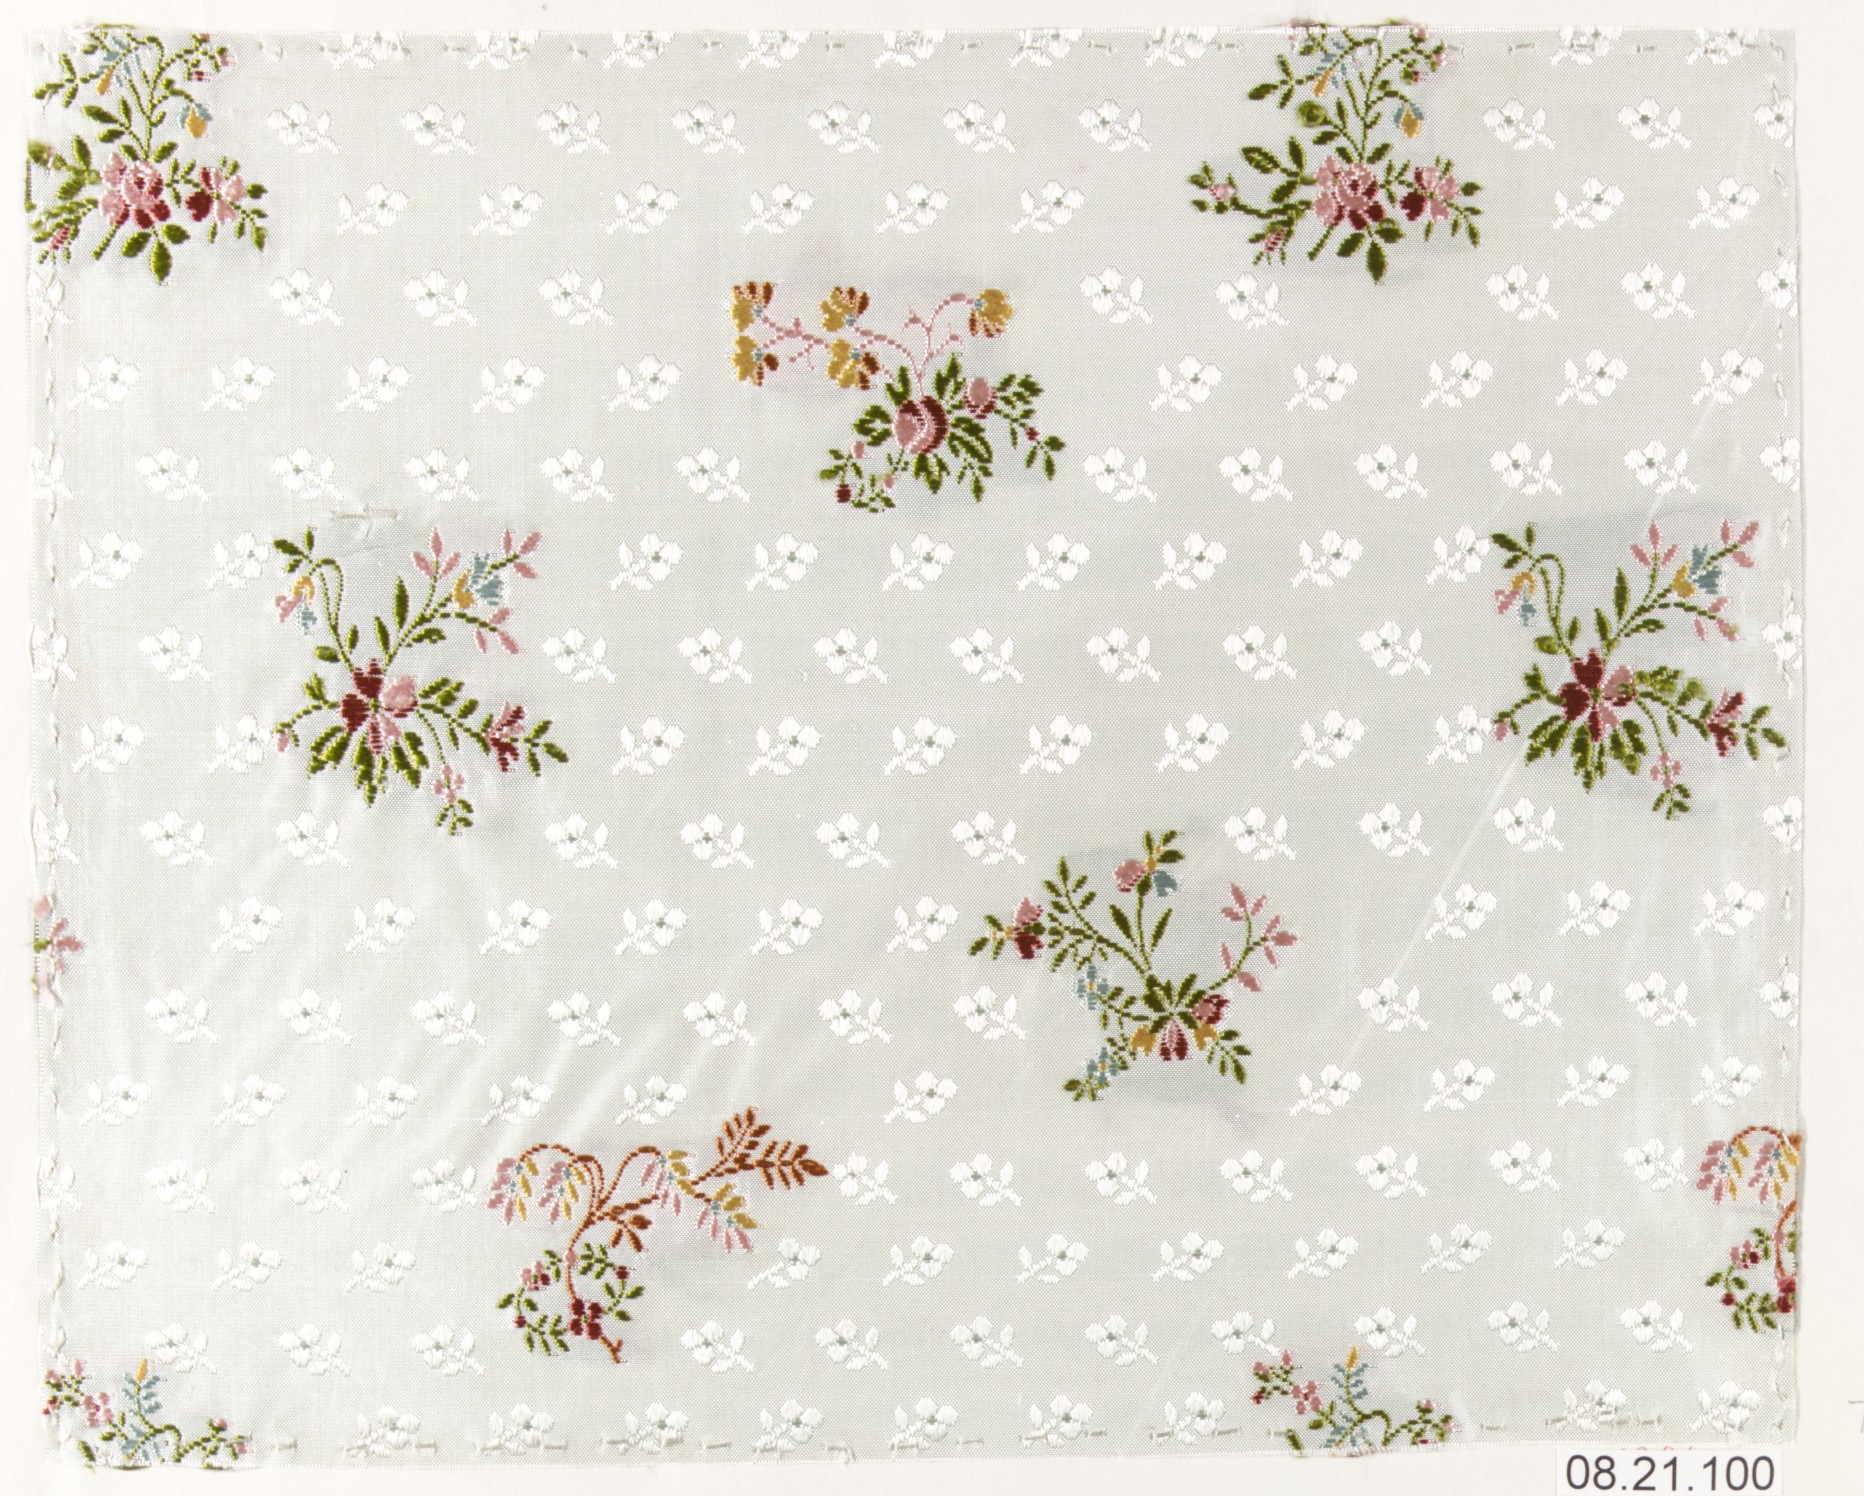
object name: textile sample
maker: Anonymous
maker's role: designer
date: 1900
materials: silk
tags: flowers